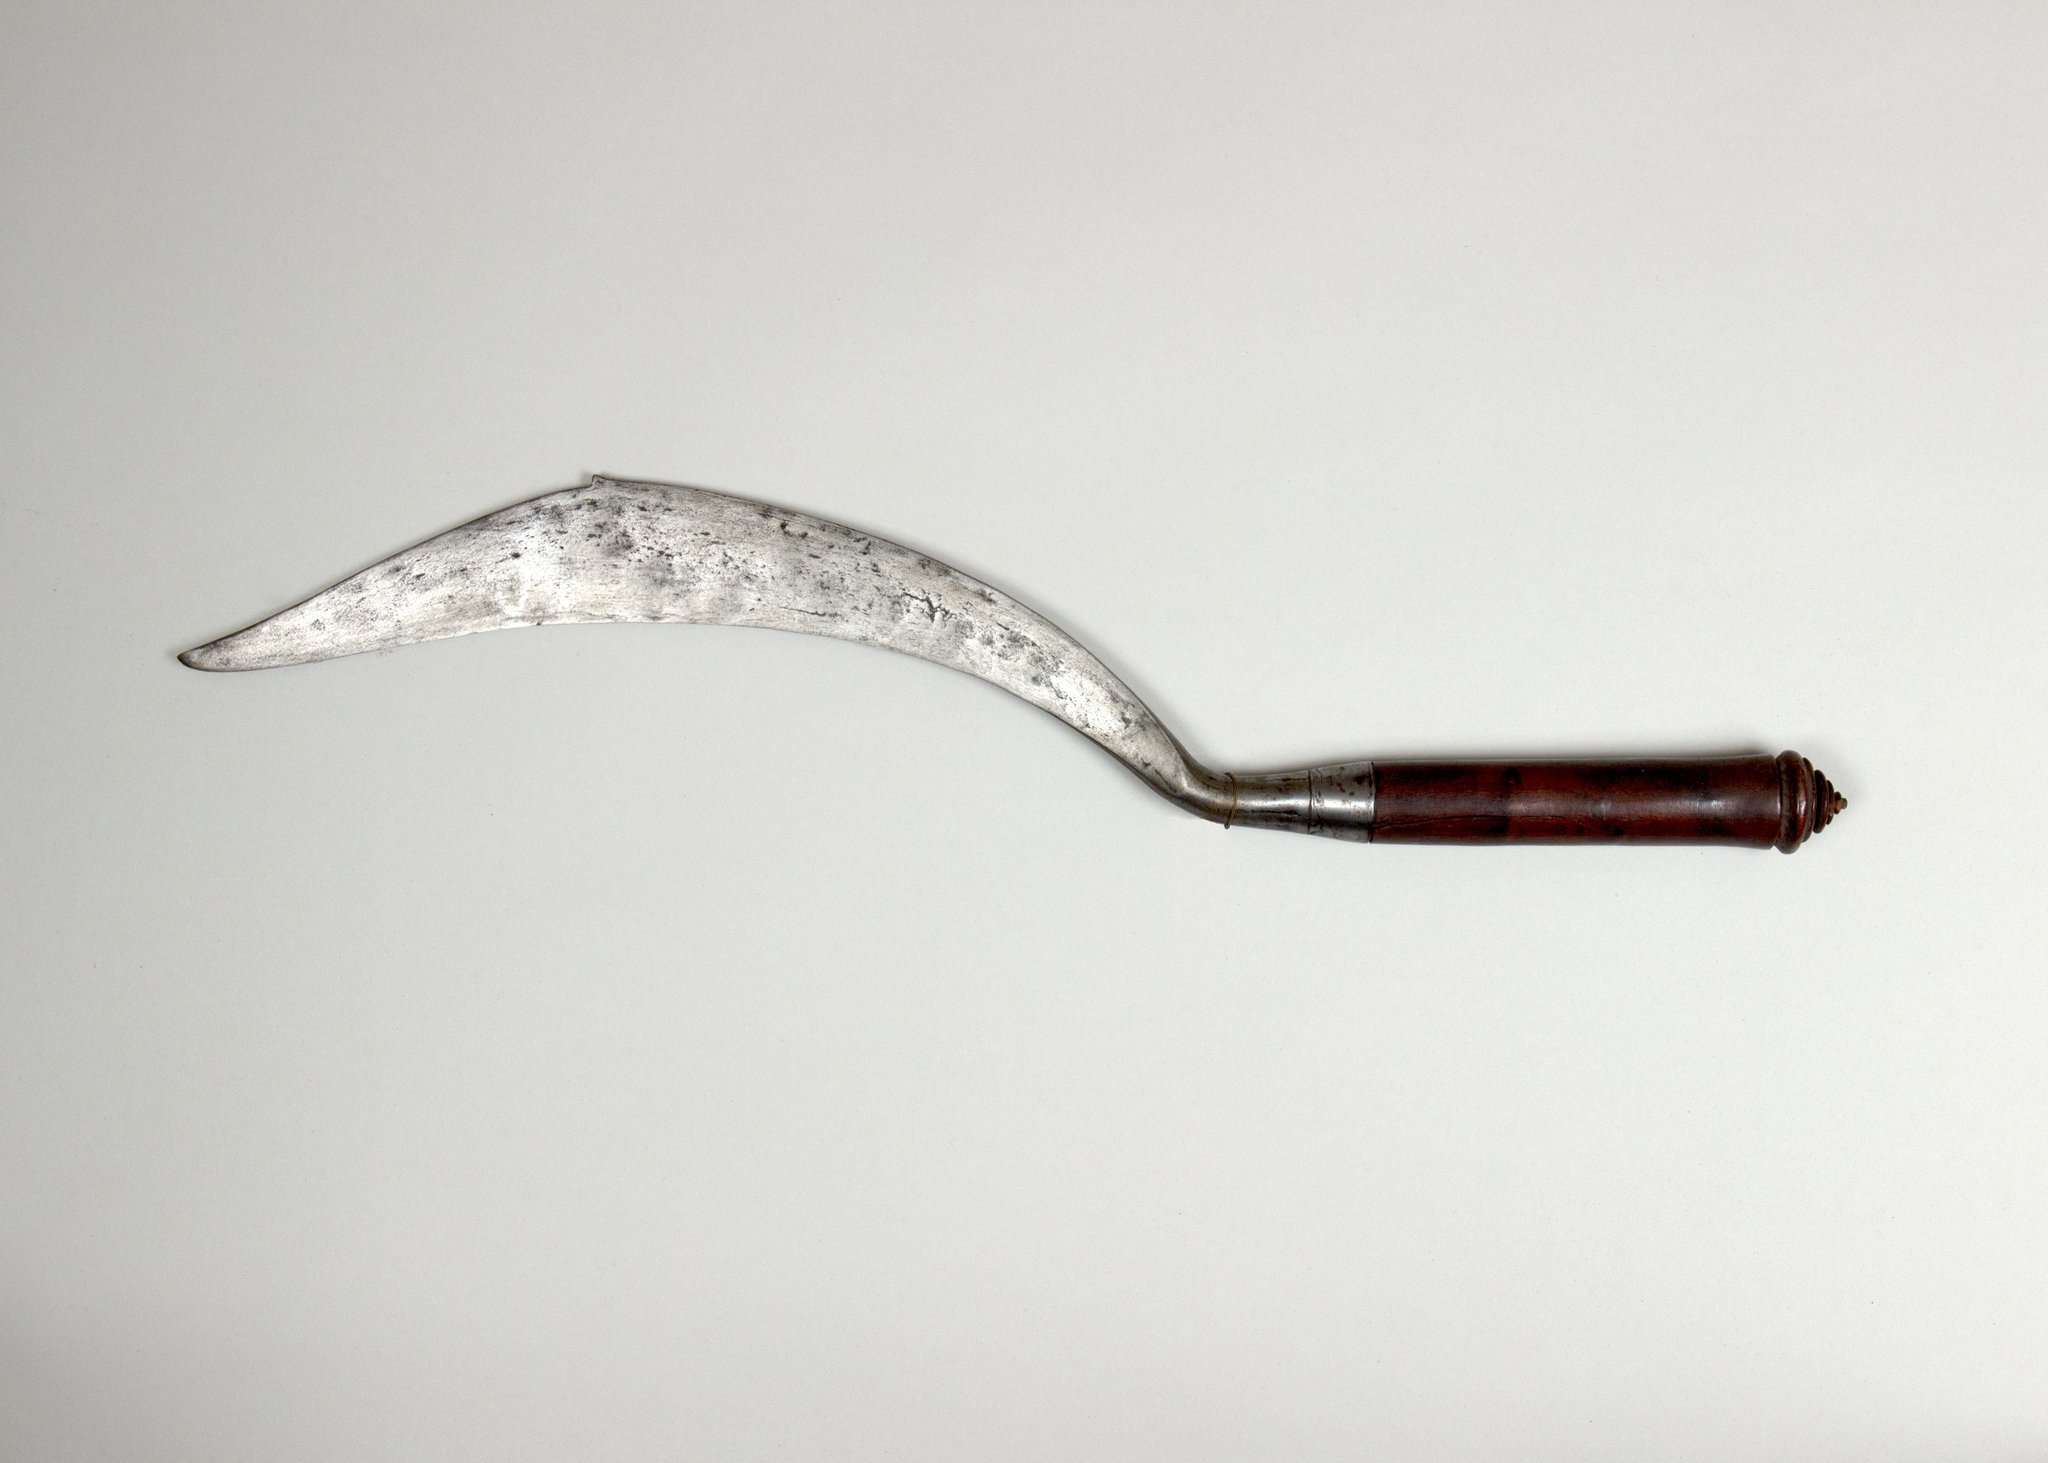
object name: sword parang ginah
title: Sword (Parang Ginah)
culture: malayan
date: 1701-1900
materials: wood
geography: malaysia